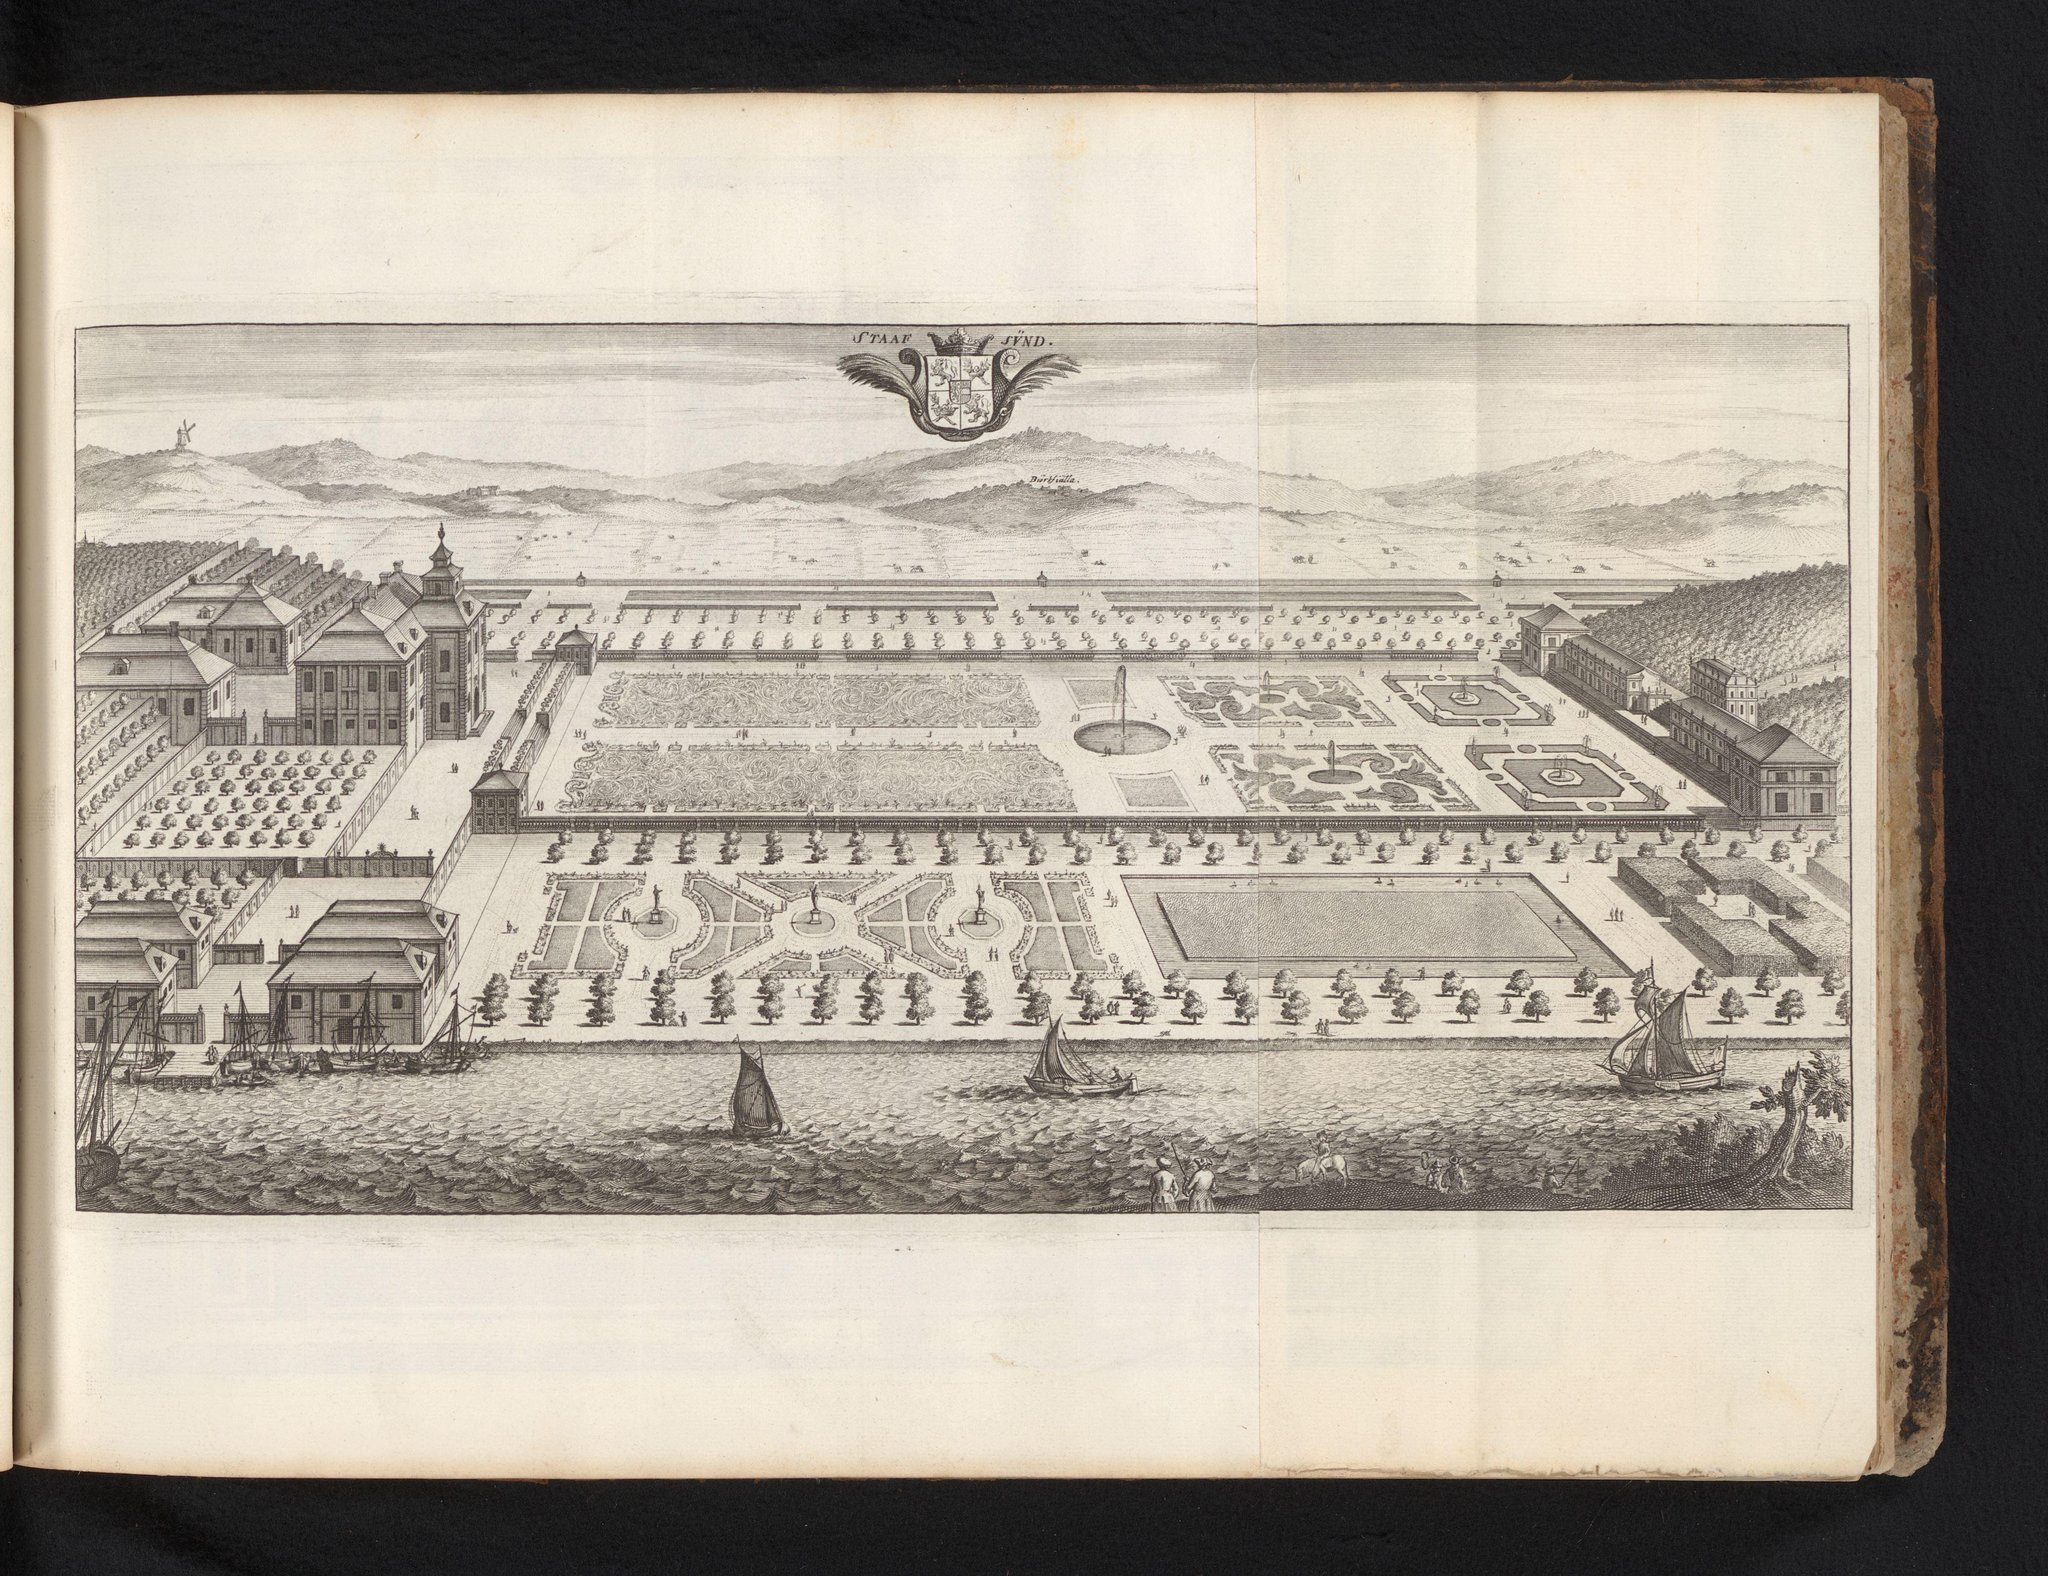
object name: print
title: Staafsund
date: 1690-1696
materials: paper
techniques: etching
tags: garden, housing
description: Kungliga Biblioteket, 'Suecia': http://www.kb.se/samlingarna/Kartor-bilder/Suecia-antiqua/ (geraadpleegd november 2016).